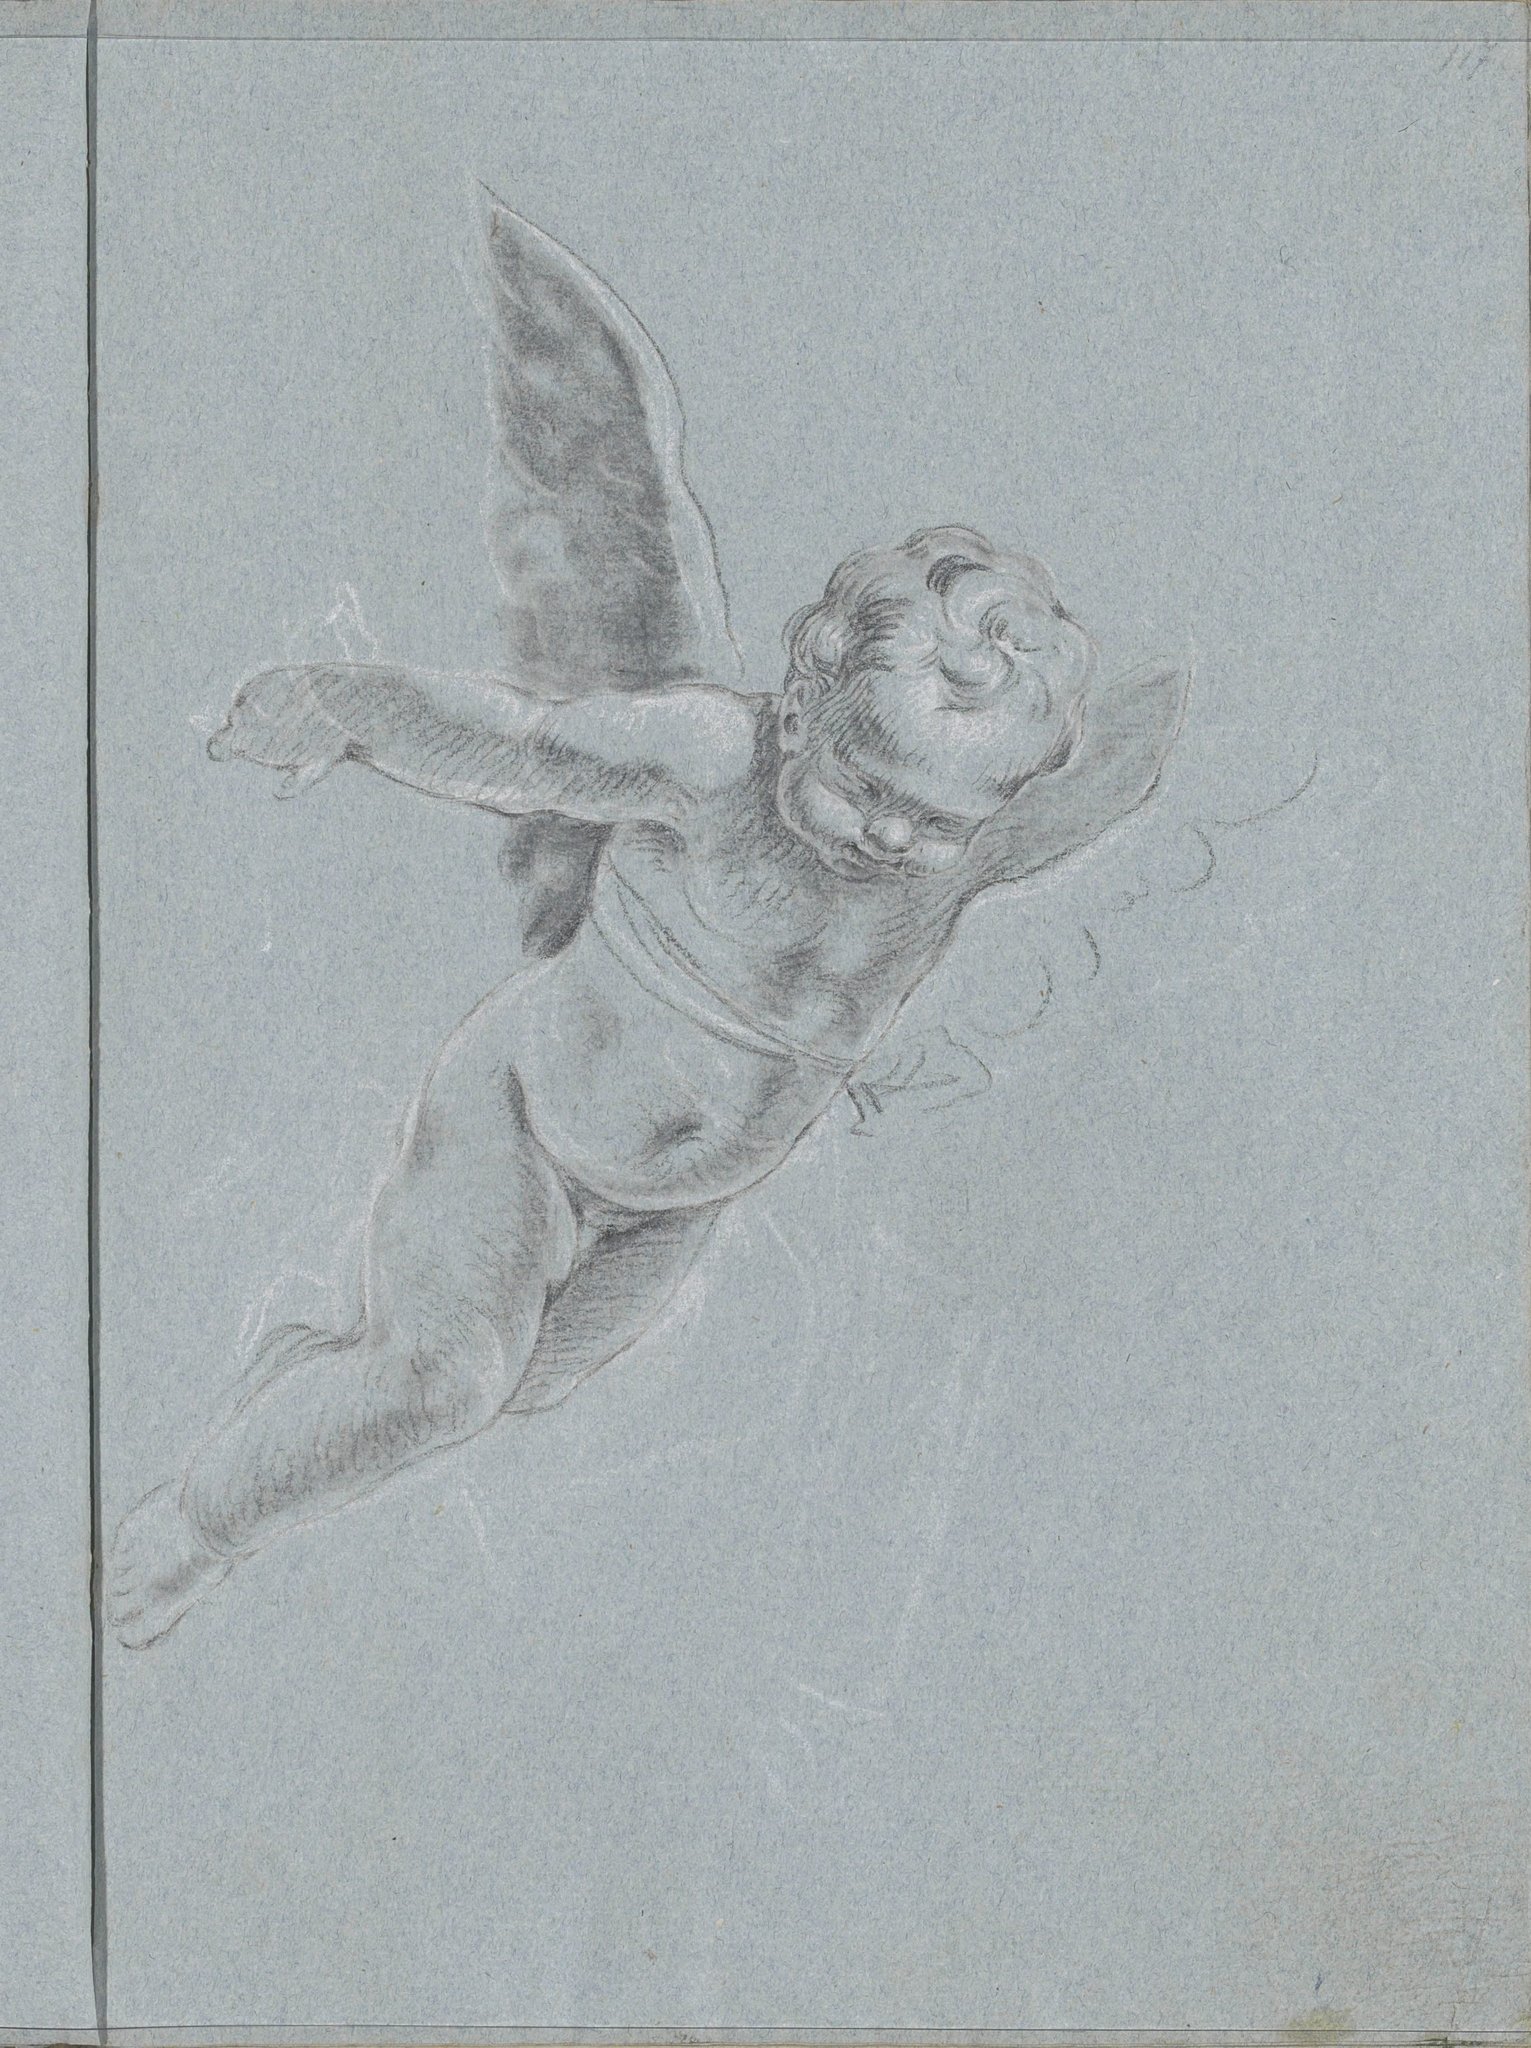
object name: sketchbook leaf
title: Vliegende putto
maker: lorenzo baldissera tiepolo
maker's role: draughtsman, print maker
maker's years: 1736-1776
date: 1751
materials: chalk, paper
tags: cupids: 'amores', 'amoretti', 'putti'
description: Bladzijde 117 uit een schetsboek met 158 bladzijden.